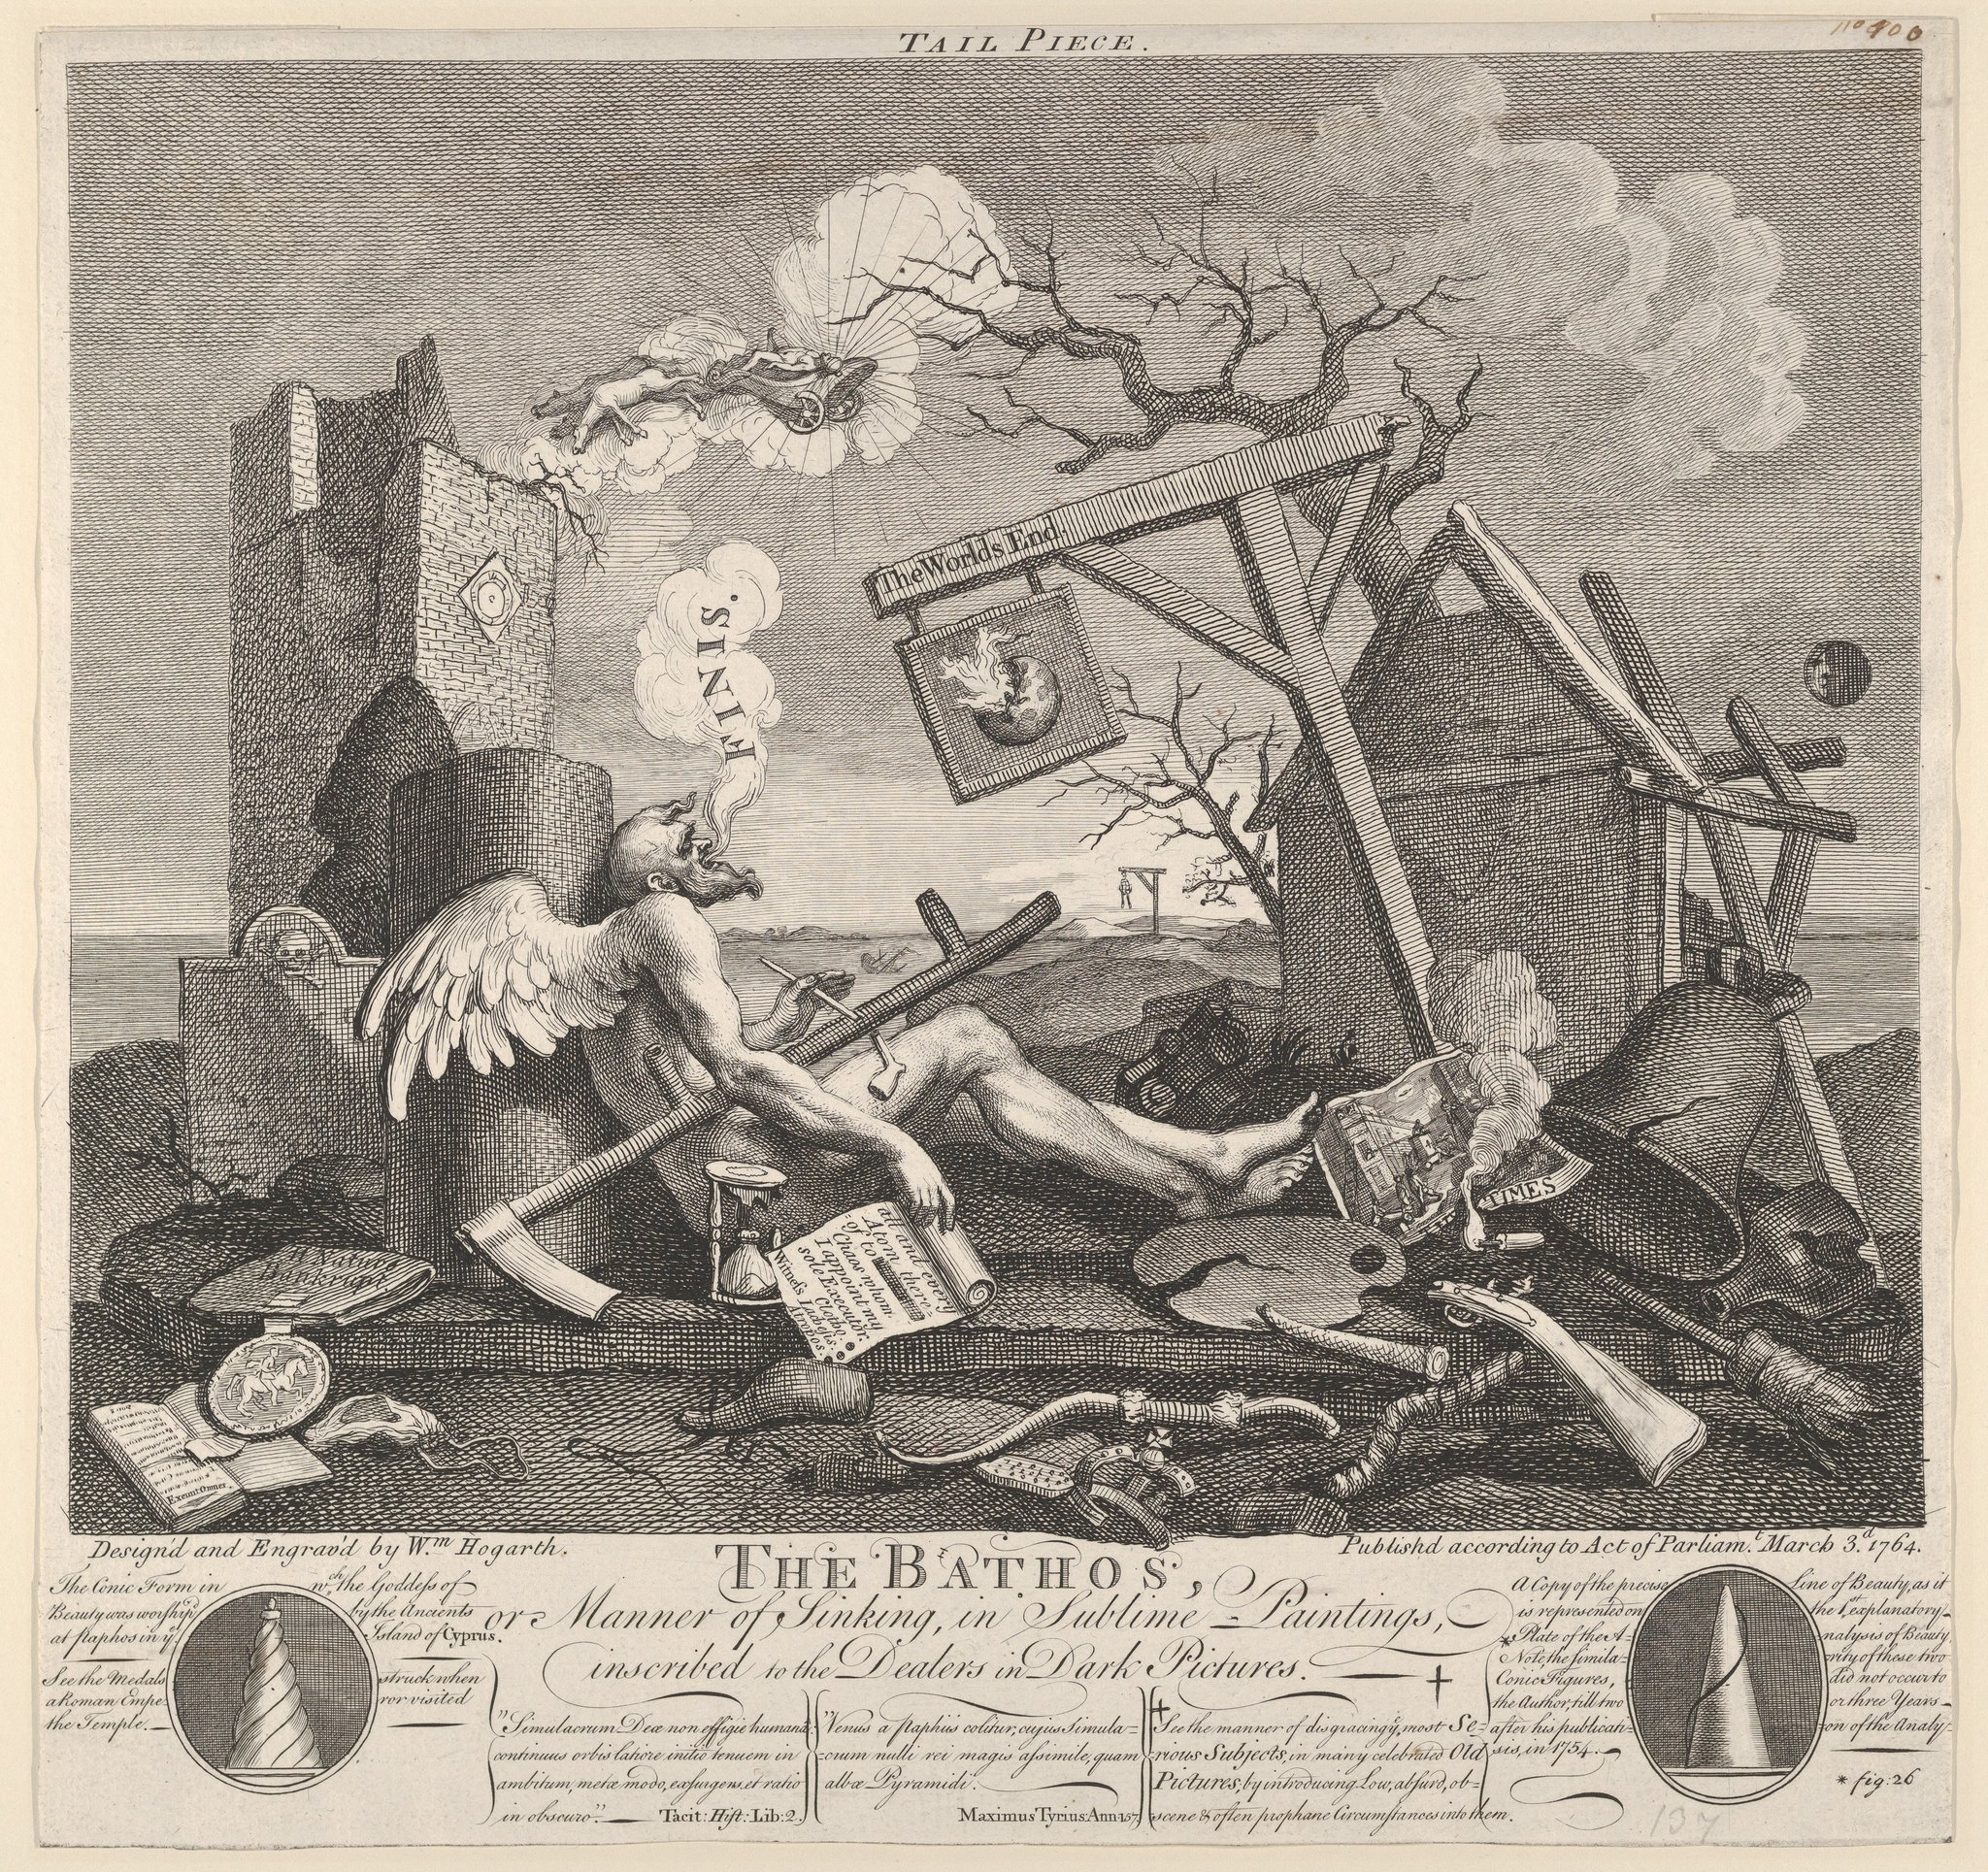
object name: print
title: Tailpiece, or The Bathos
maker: william hogarth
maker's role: artist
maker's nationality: british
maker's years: 1697-1764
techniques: engraving, etching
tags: ruins,smoking